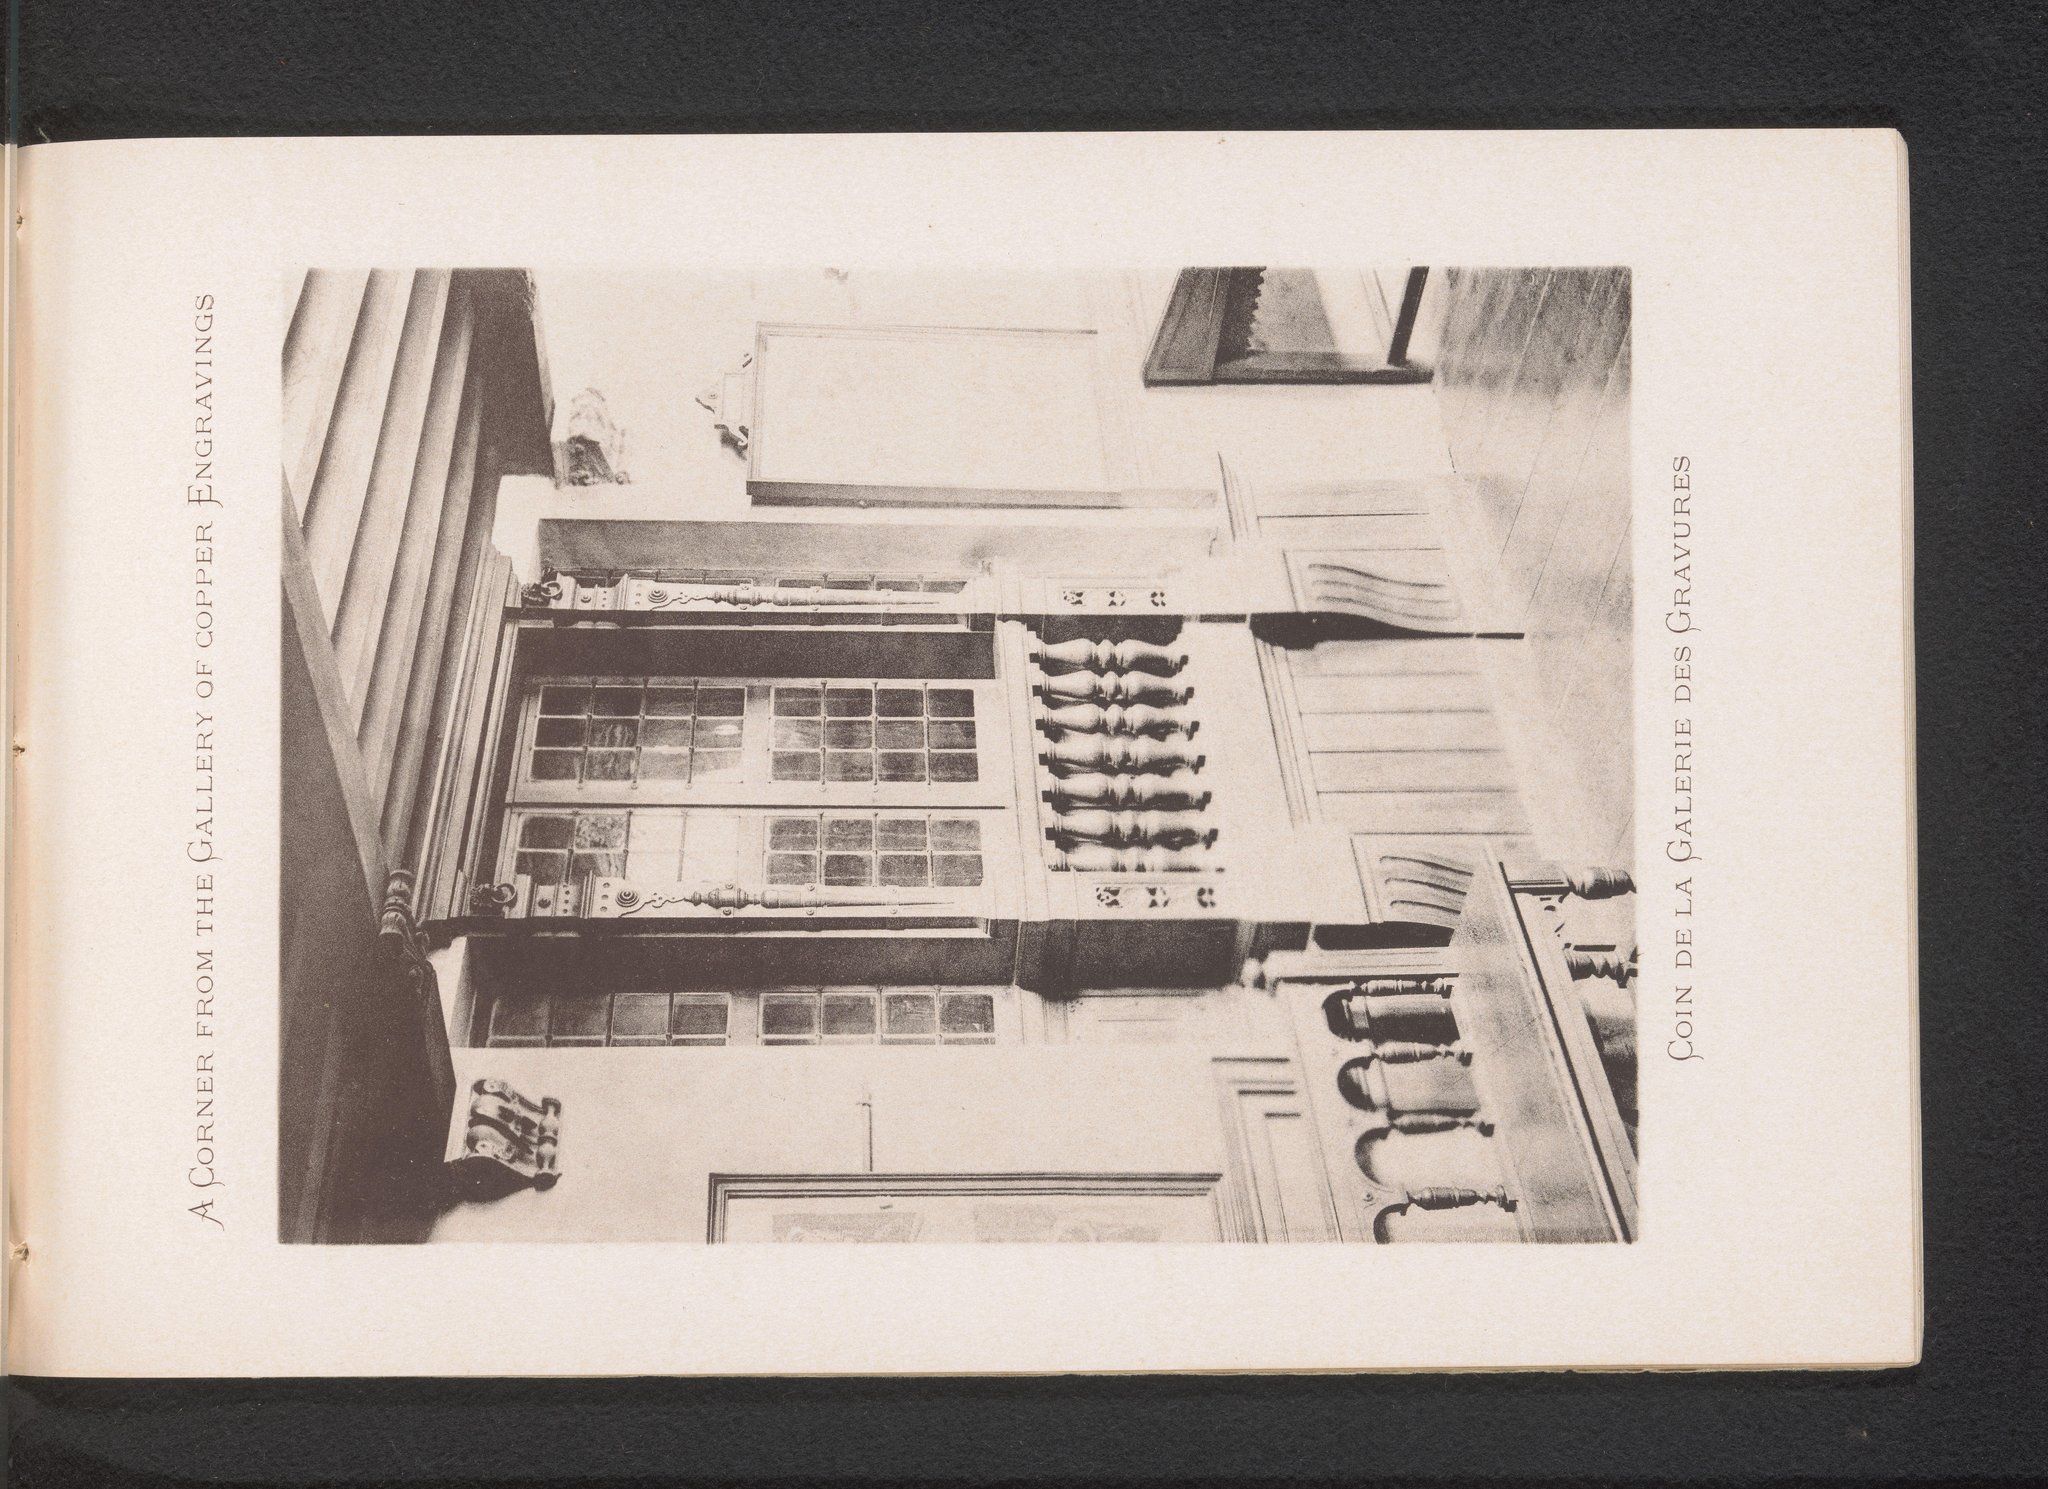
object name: page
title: Coin de la galerie des gravures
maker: Anonymous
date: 1892-1897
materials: paper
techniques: photograph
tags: permanent exhibition, museum